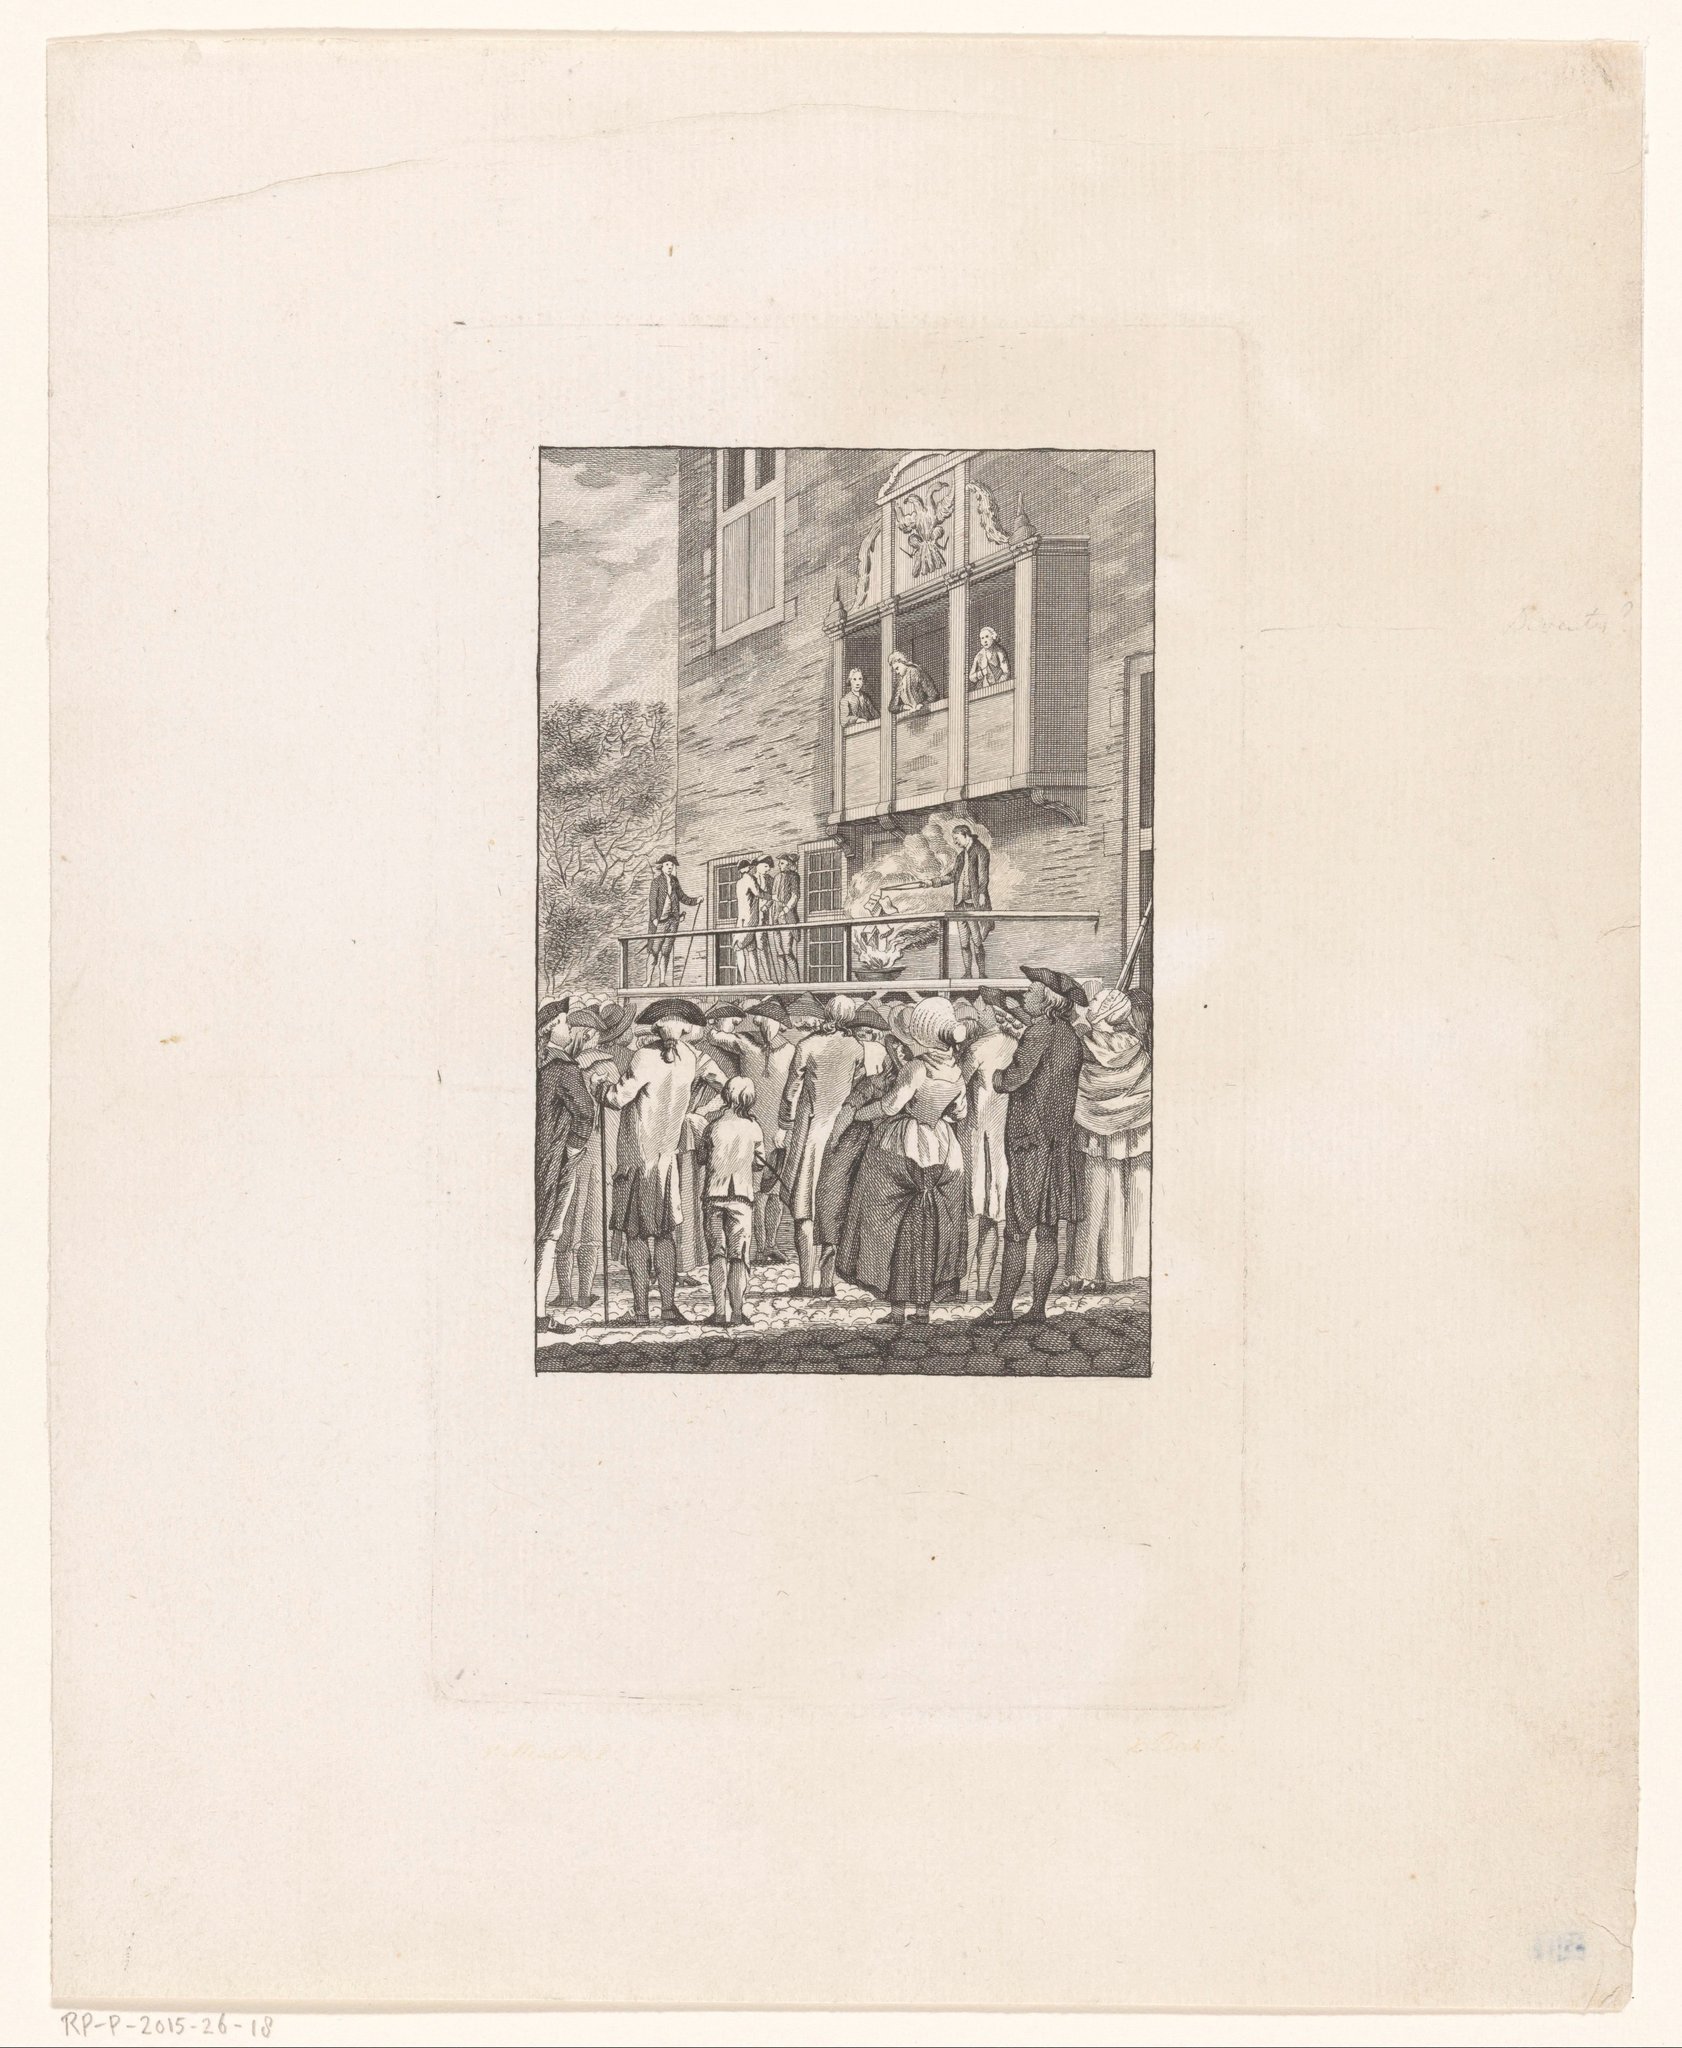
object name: print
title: Verbranding van De Post van de Neder-Rhijn op schavot voor stadhuis te Arnhem op 22 april 1786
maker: jan lucas van der beek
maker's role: draughtsman, print maker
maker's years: 1753-1818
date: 1786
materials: paper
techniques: etching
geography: amsterdam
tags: law and jurisprudence (+ place of execution), burning of books, arnhem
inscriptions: collector's mark: Lugt 2228, collector's mark: Lugt 4780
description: Openbare executie door verbranding door een beul van een exemplaar van het patriotse tijdschrift De Post van den Neder-Rhijn, op een schavot voor het oude stadhuis van Arnhem, 22 april 1786. Actie door tegenstanders van het blad waarin de vrijlating van de van moord beschuldigde korporaal van Douglas werd veroordeeld.